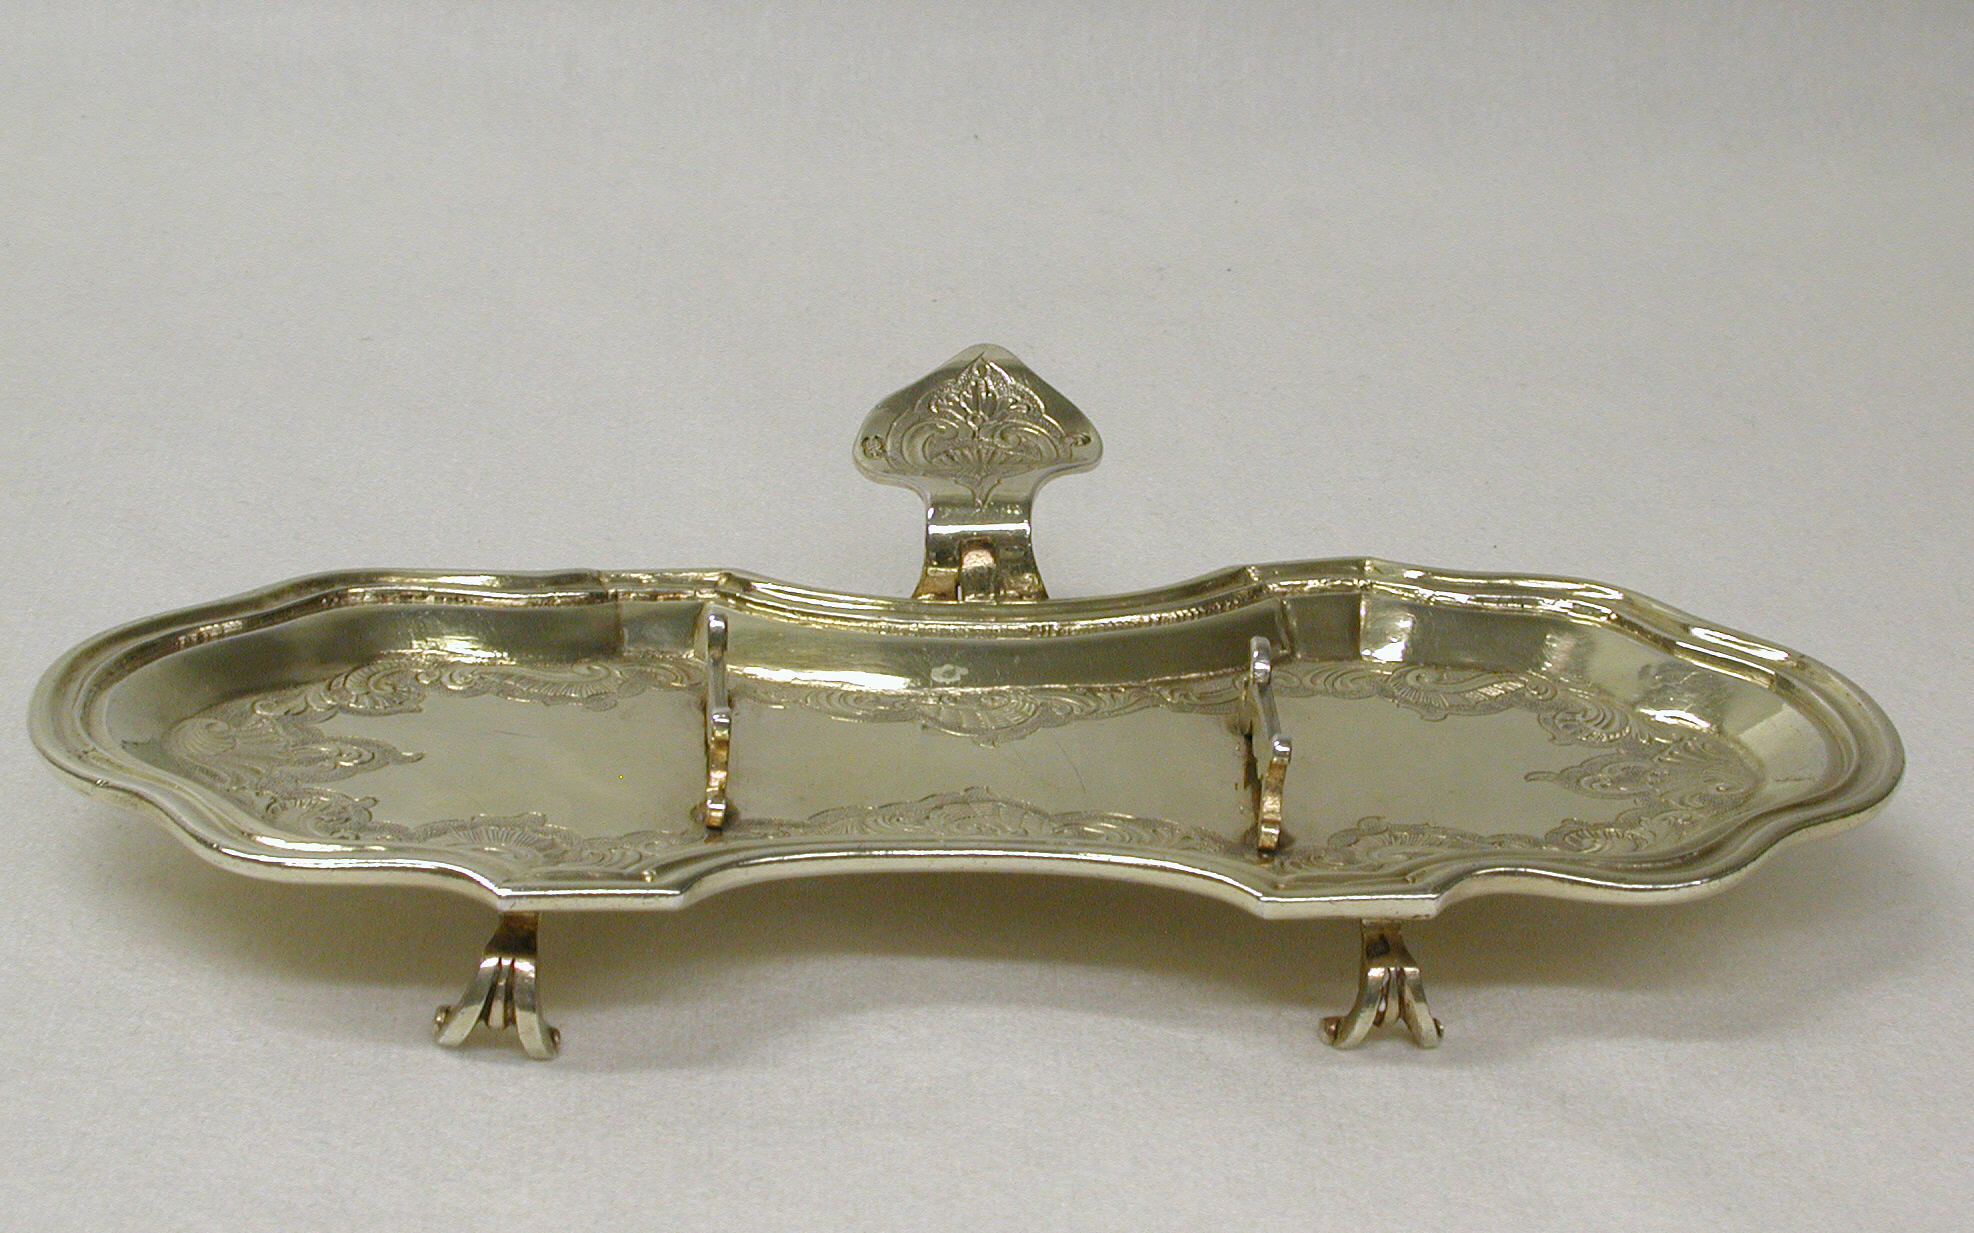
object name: stand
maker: friedrich schwestermuller ii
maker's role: maker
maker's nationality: german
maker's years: 1713-1752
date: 1743-1745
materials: silver gilt